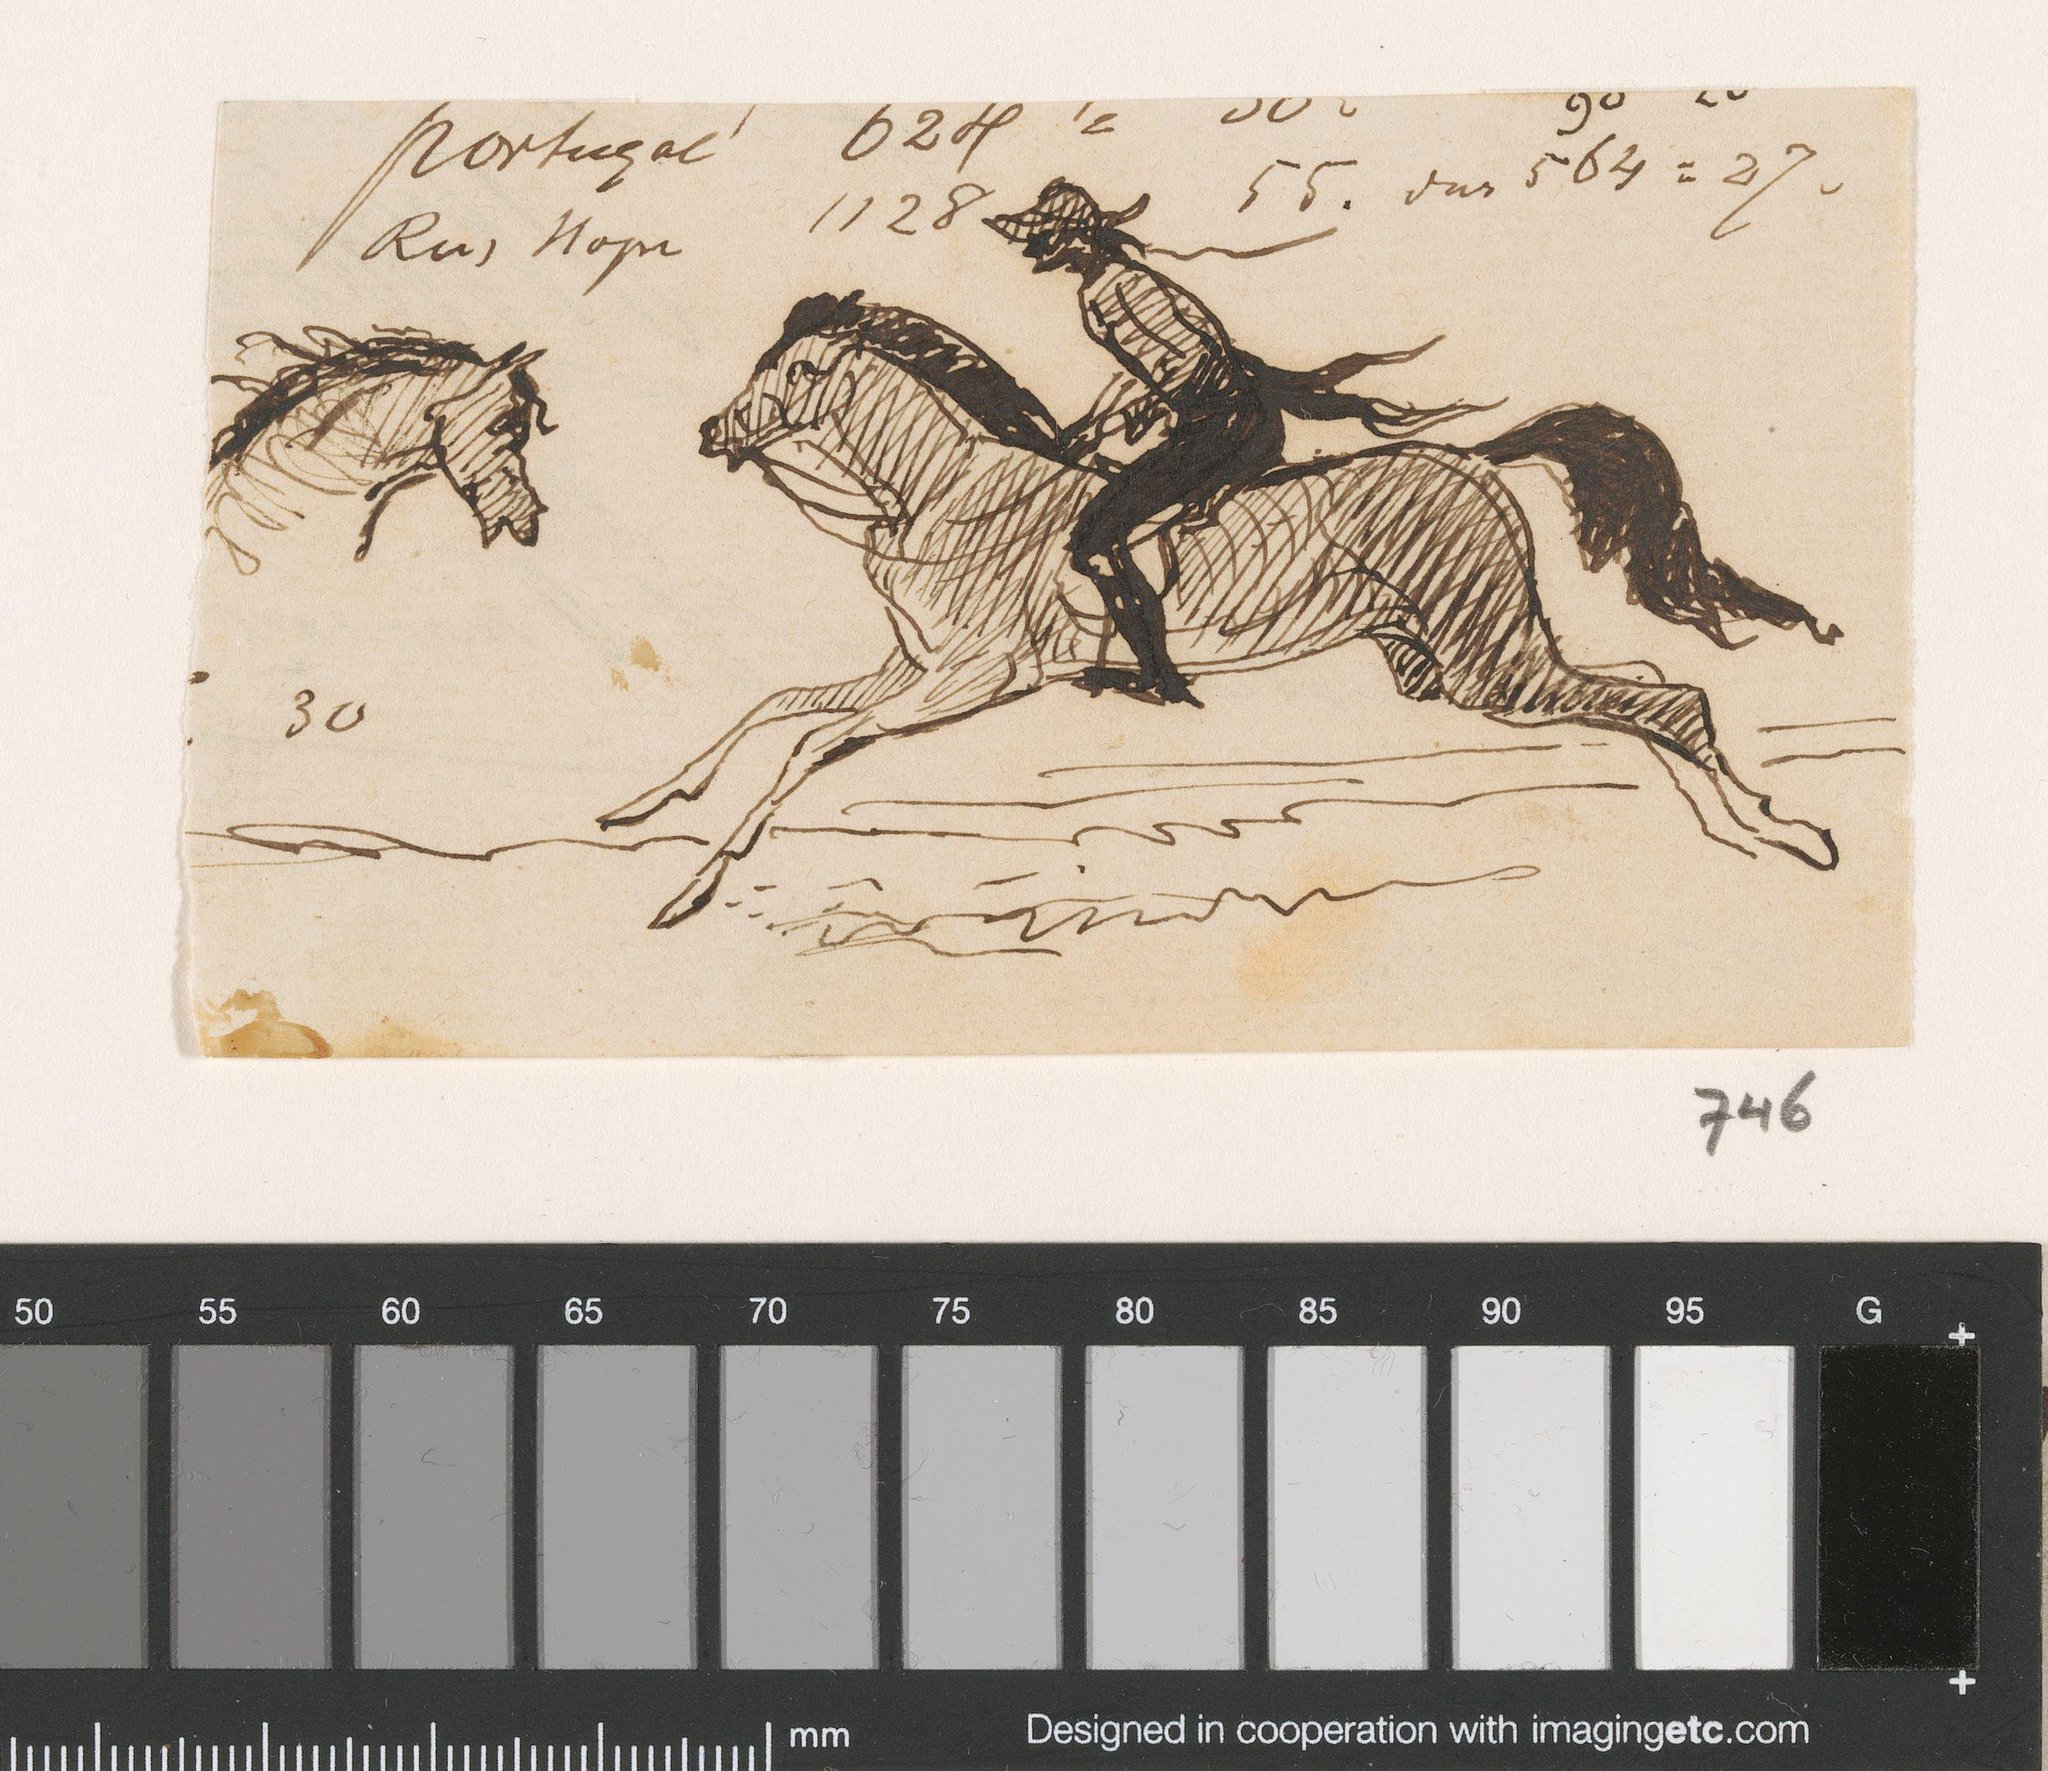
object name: drawing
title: Man rijdend op een paard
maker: johannes tavenraat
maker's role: draughtsman, painter, print maker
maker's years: 1809-1881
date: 1840-1880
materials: ink, paper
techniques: pen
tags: riding a horse, ass, or mule; rider, horseman, horse